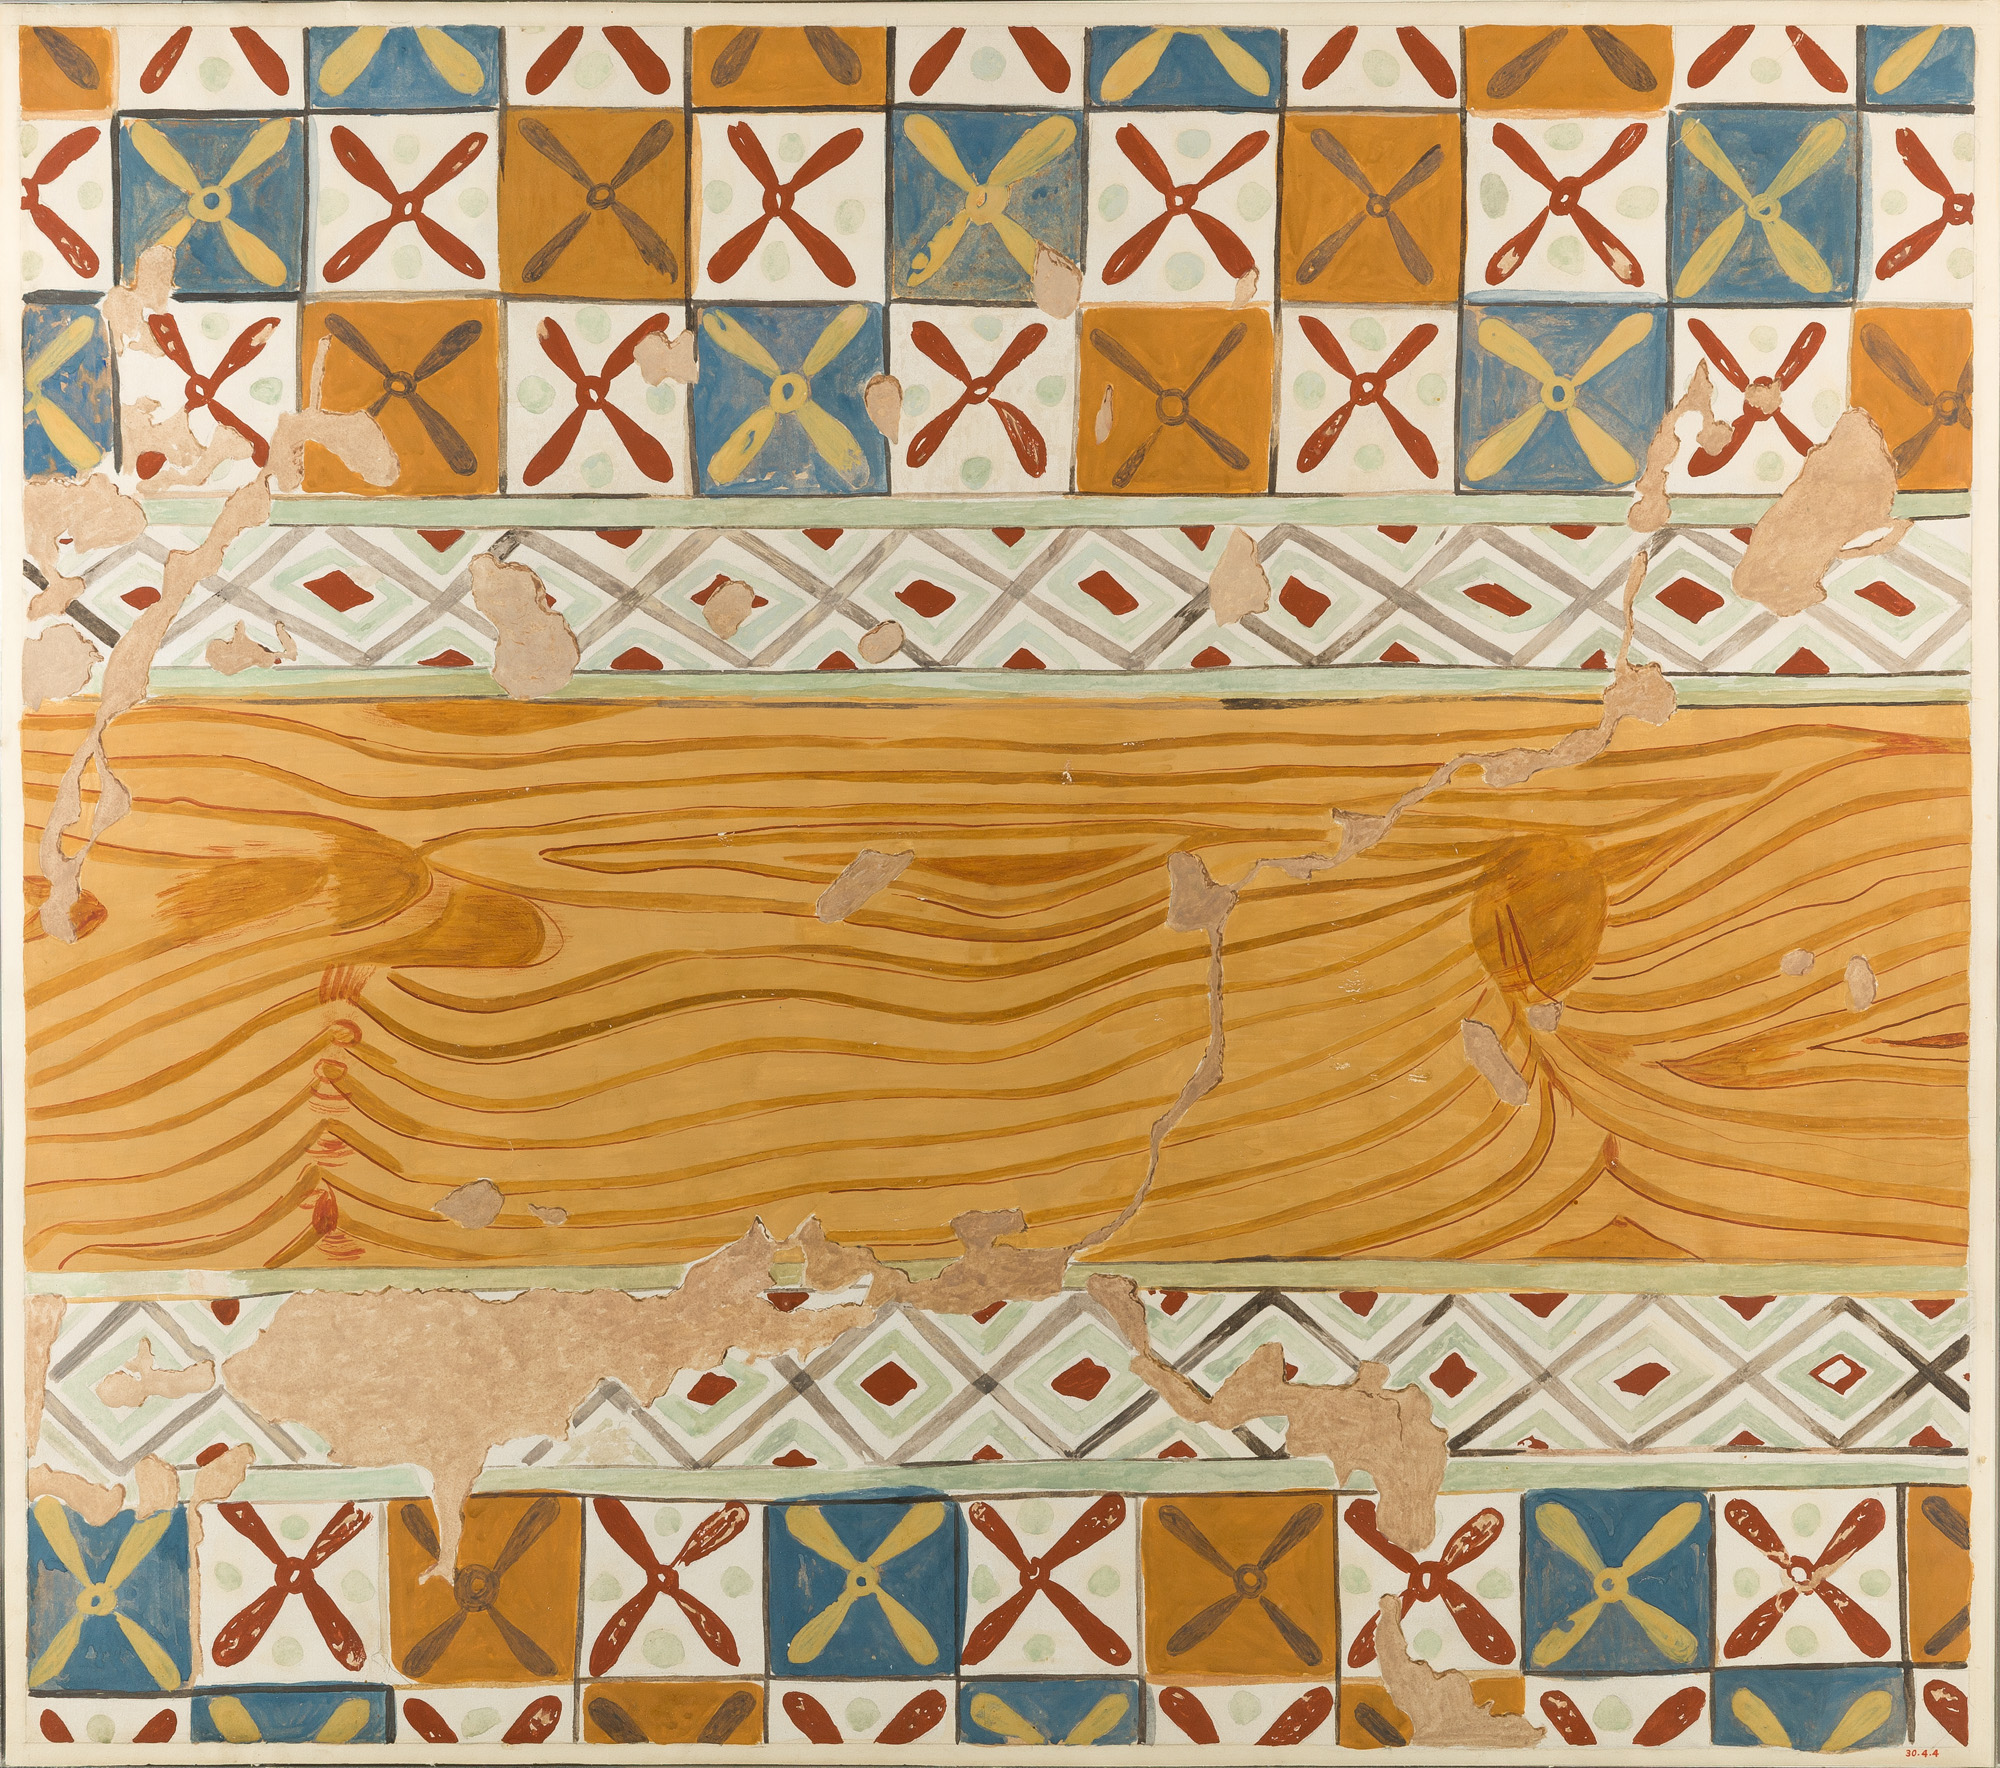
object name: facsimile, tetiky tt 15, ceiling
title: Ceiling Decoration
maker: charles k. wilkinson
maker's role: artist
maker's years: 1897-1986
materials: paper, paint